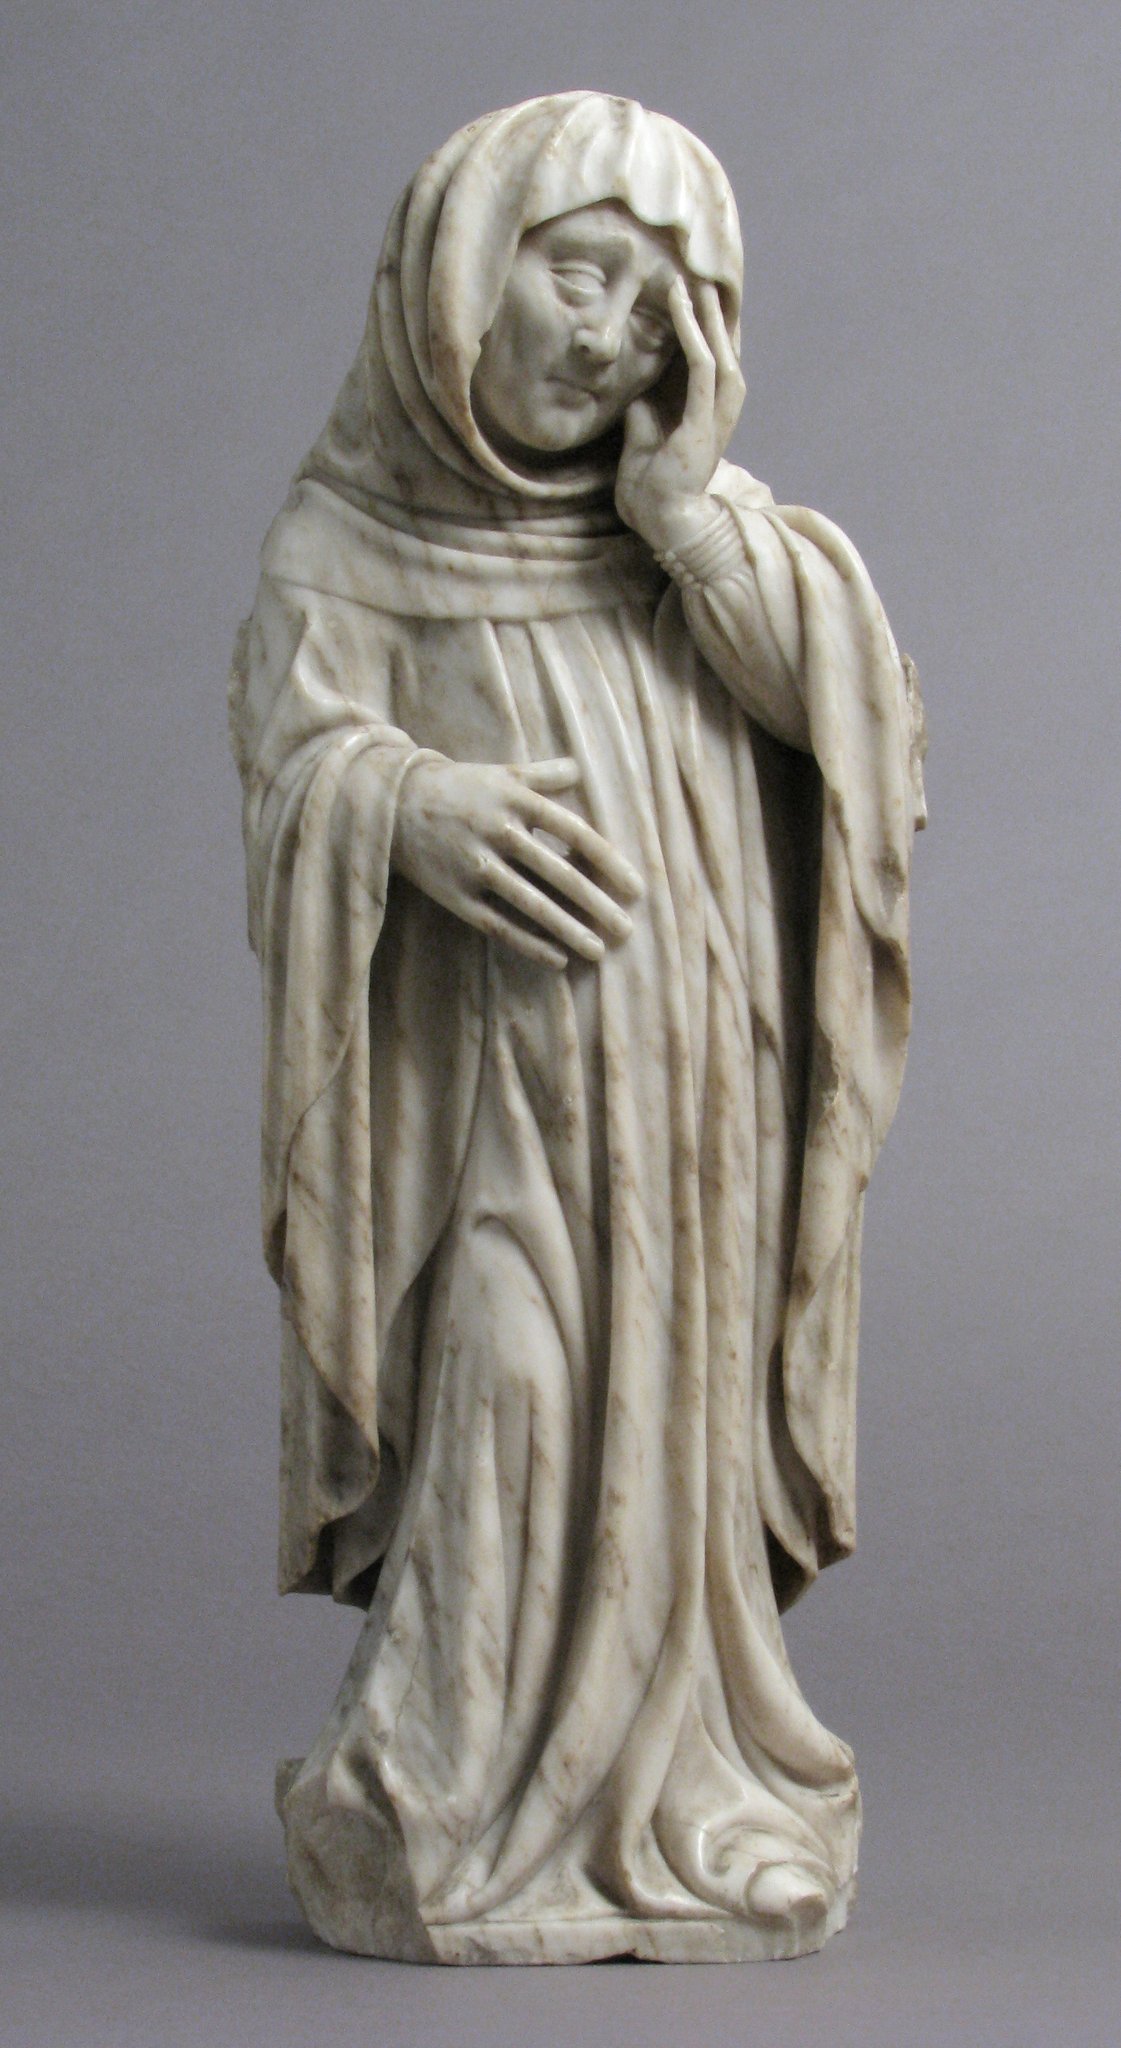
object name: statuette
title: Mourner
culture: catalan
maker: pere oller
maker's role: artist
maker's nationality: catalan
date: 1417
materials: alabaster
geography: spain